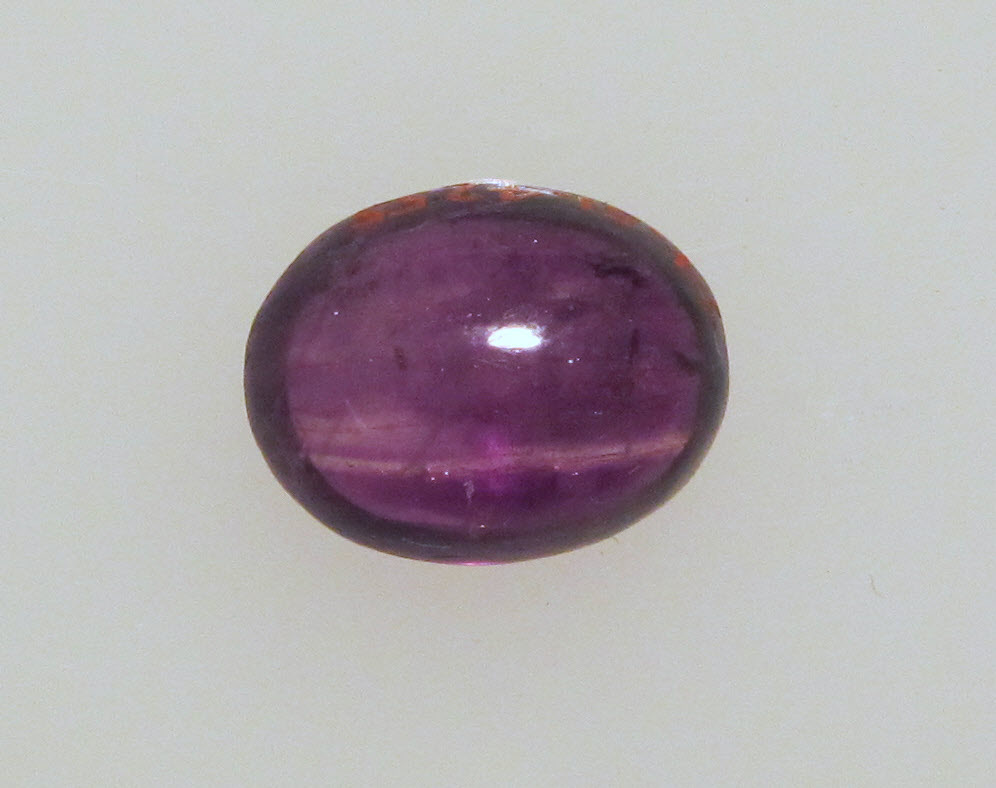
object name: intaglio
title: Intaglio ?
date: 7000 BCE-330 CE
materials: gemstone